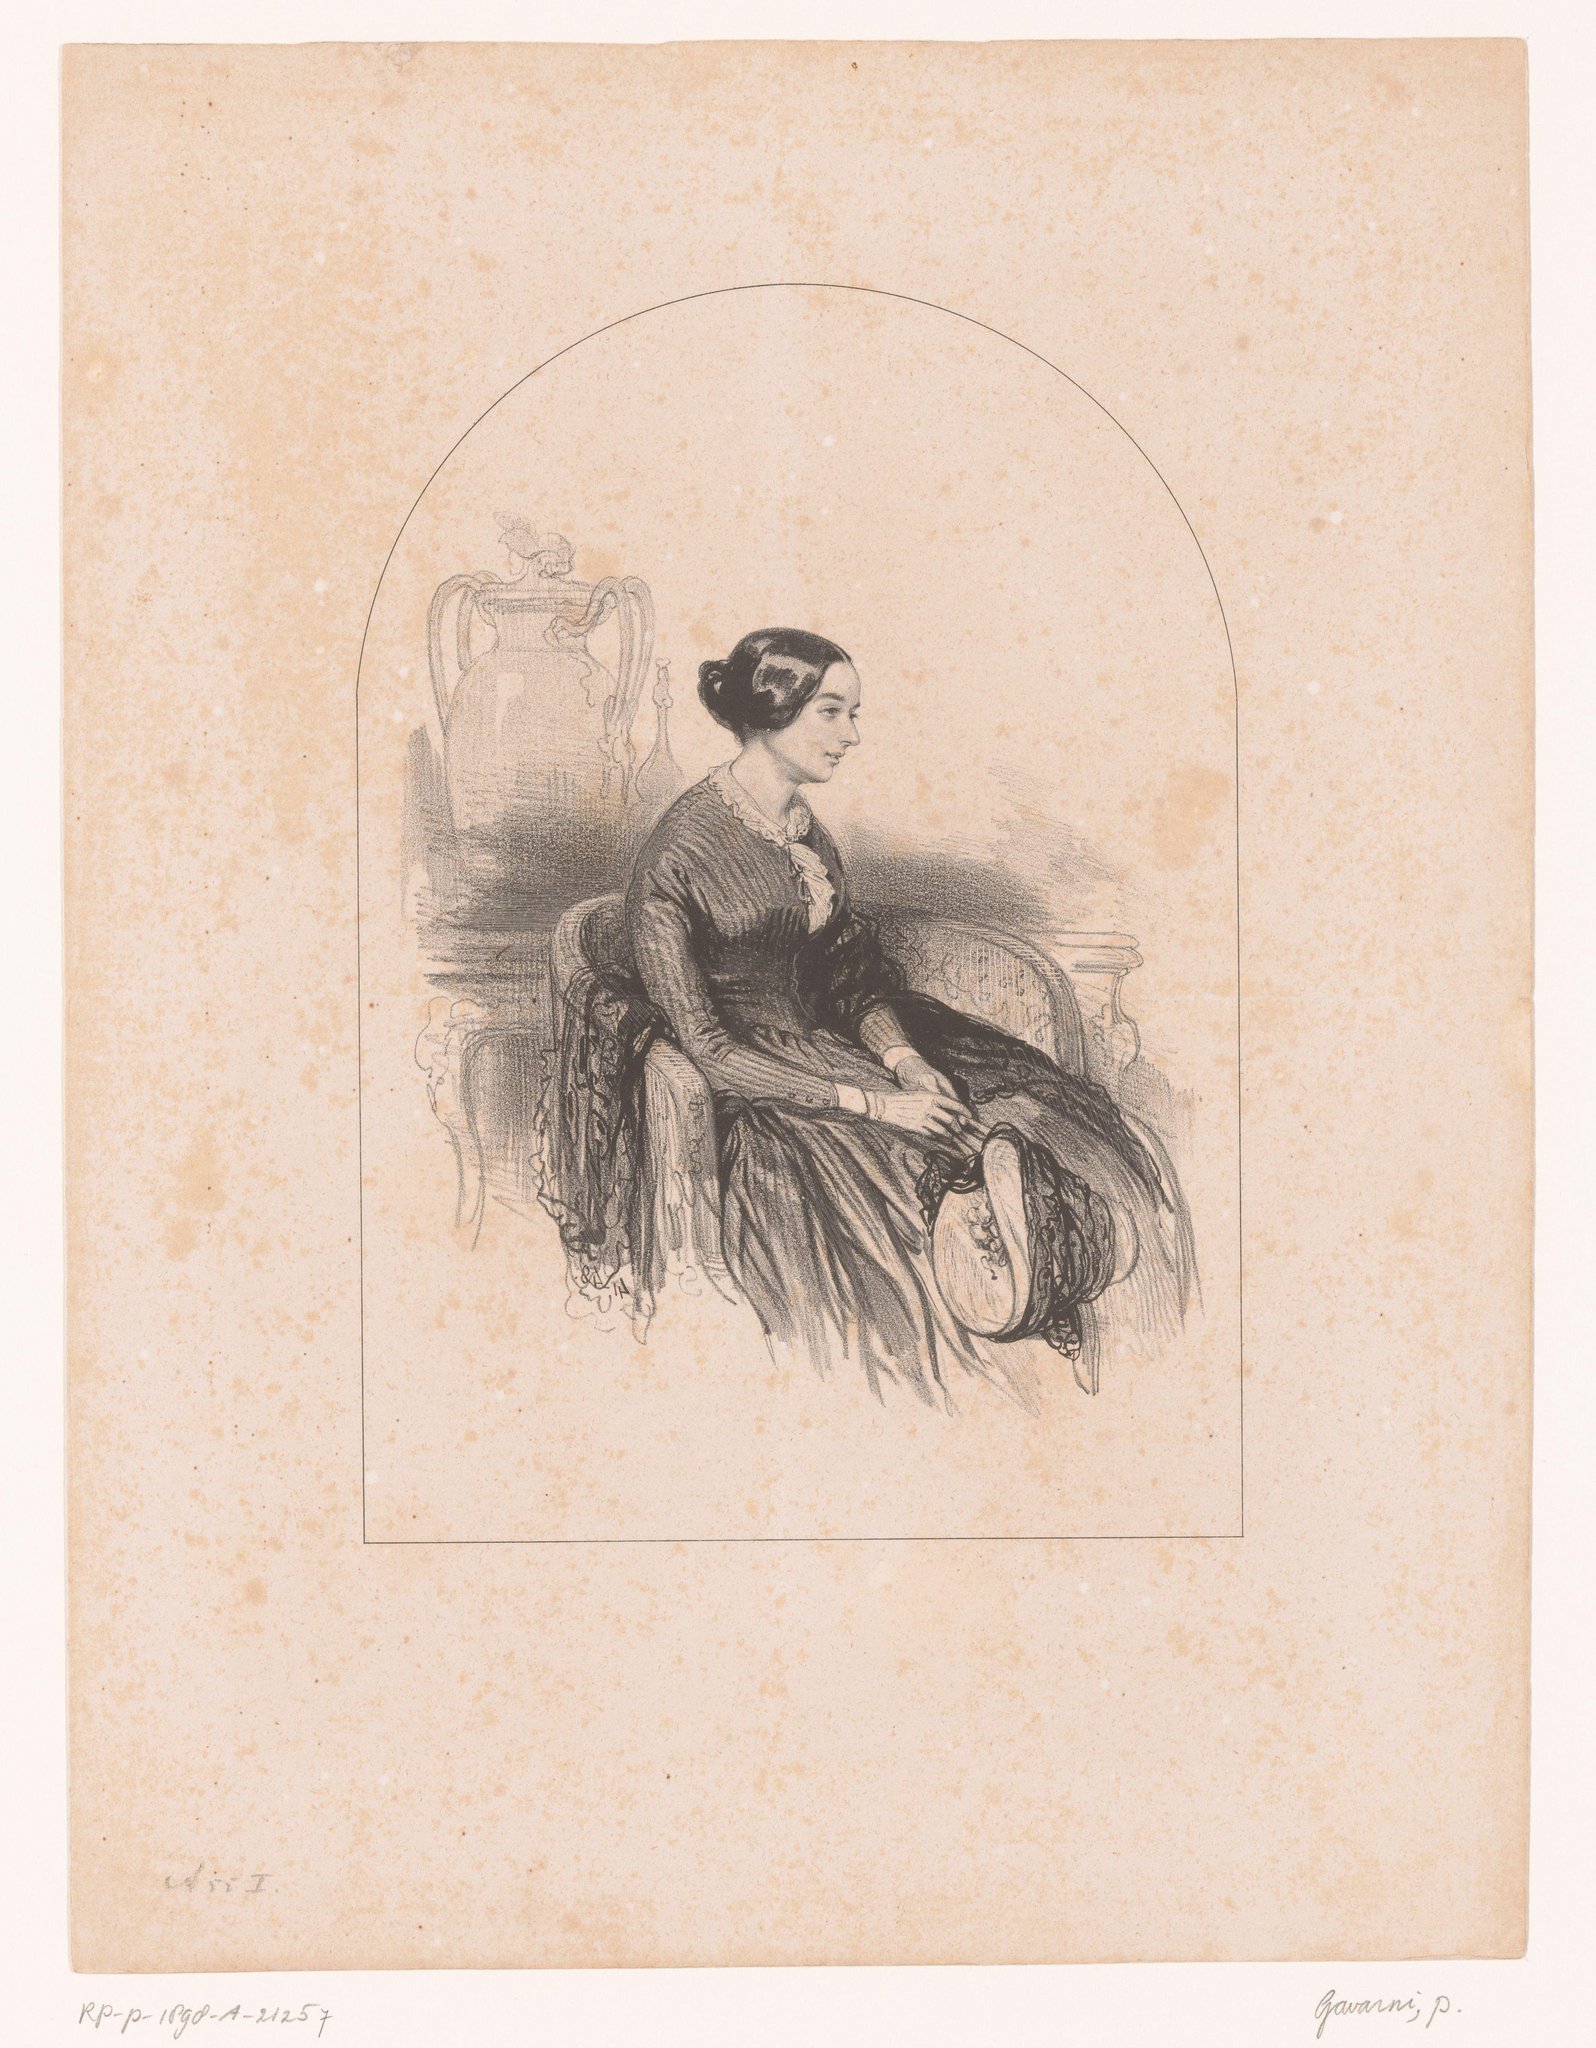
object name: print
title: Portret van Mademoiselle Nourtier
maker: paul gavarni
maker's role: draughtsman, print maker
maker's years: 1804-1866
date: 1841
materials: paper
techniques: lithograph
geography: paris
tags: sitting figure - aa - female human figure, historical persons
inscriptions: collector's mark: Lugt 964